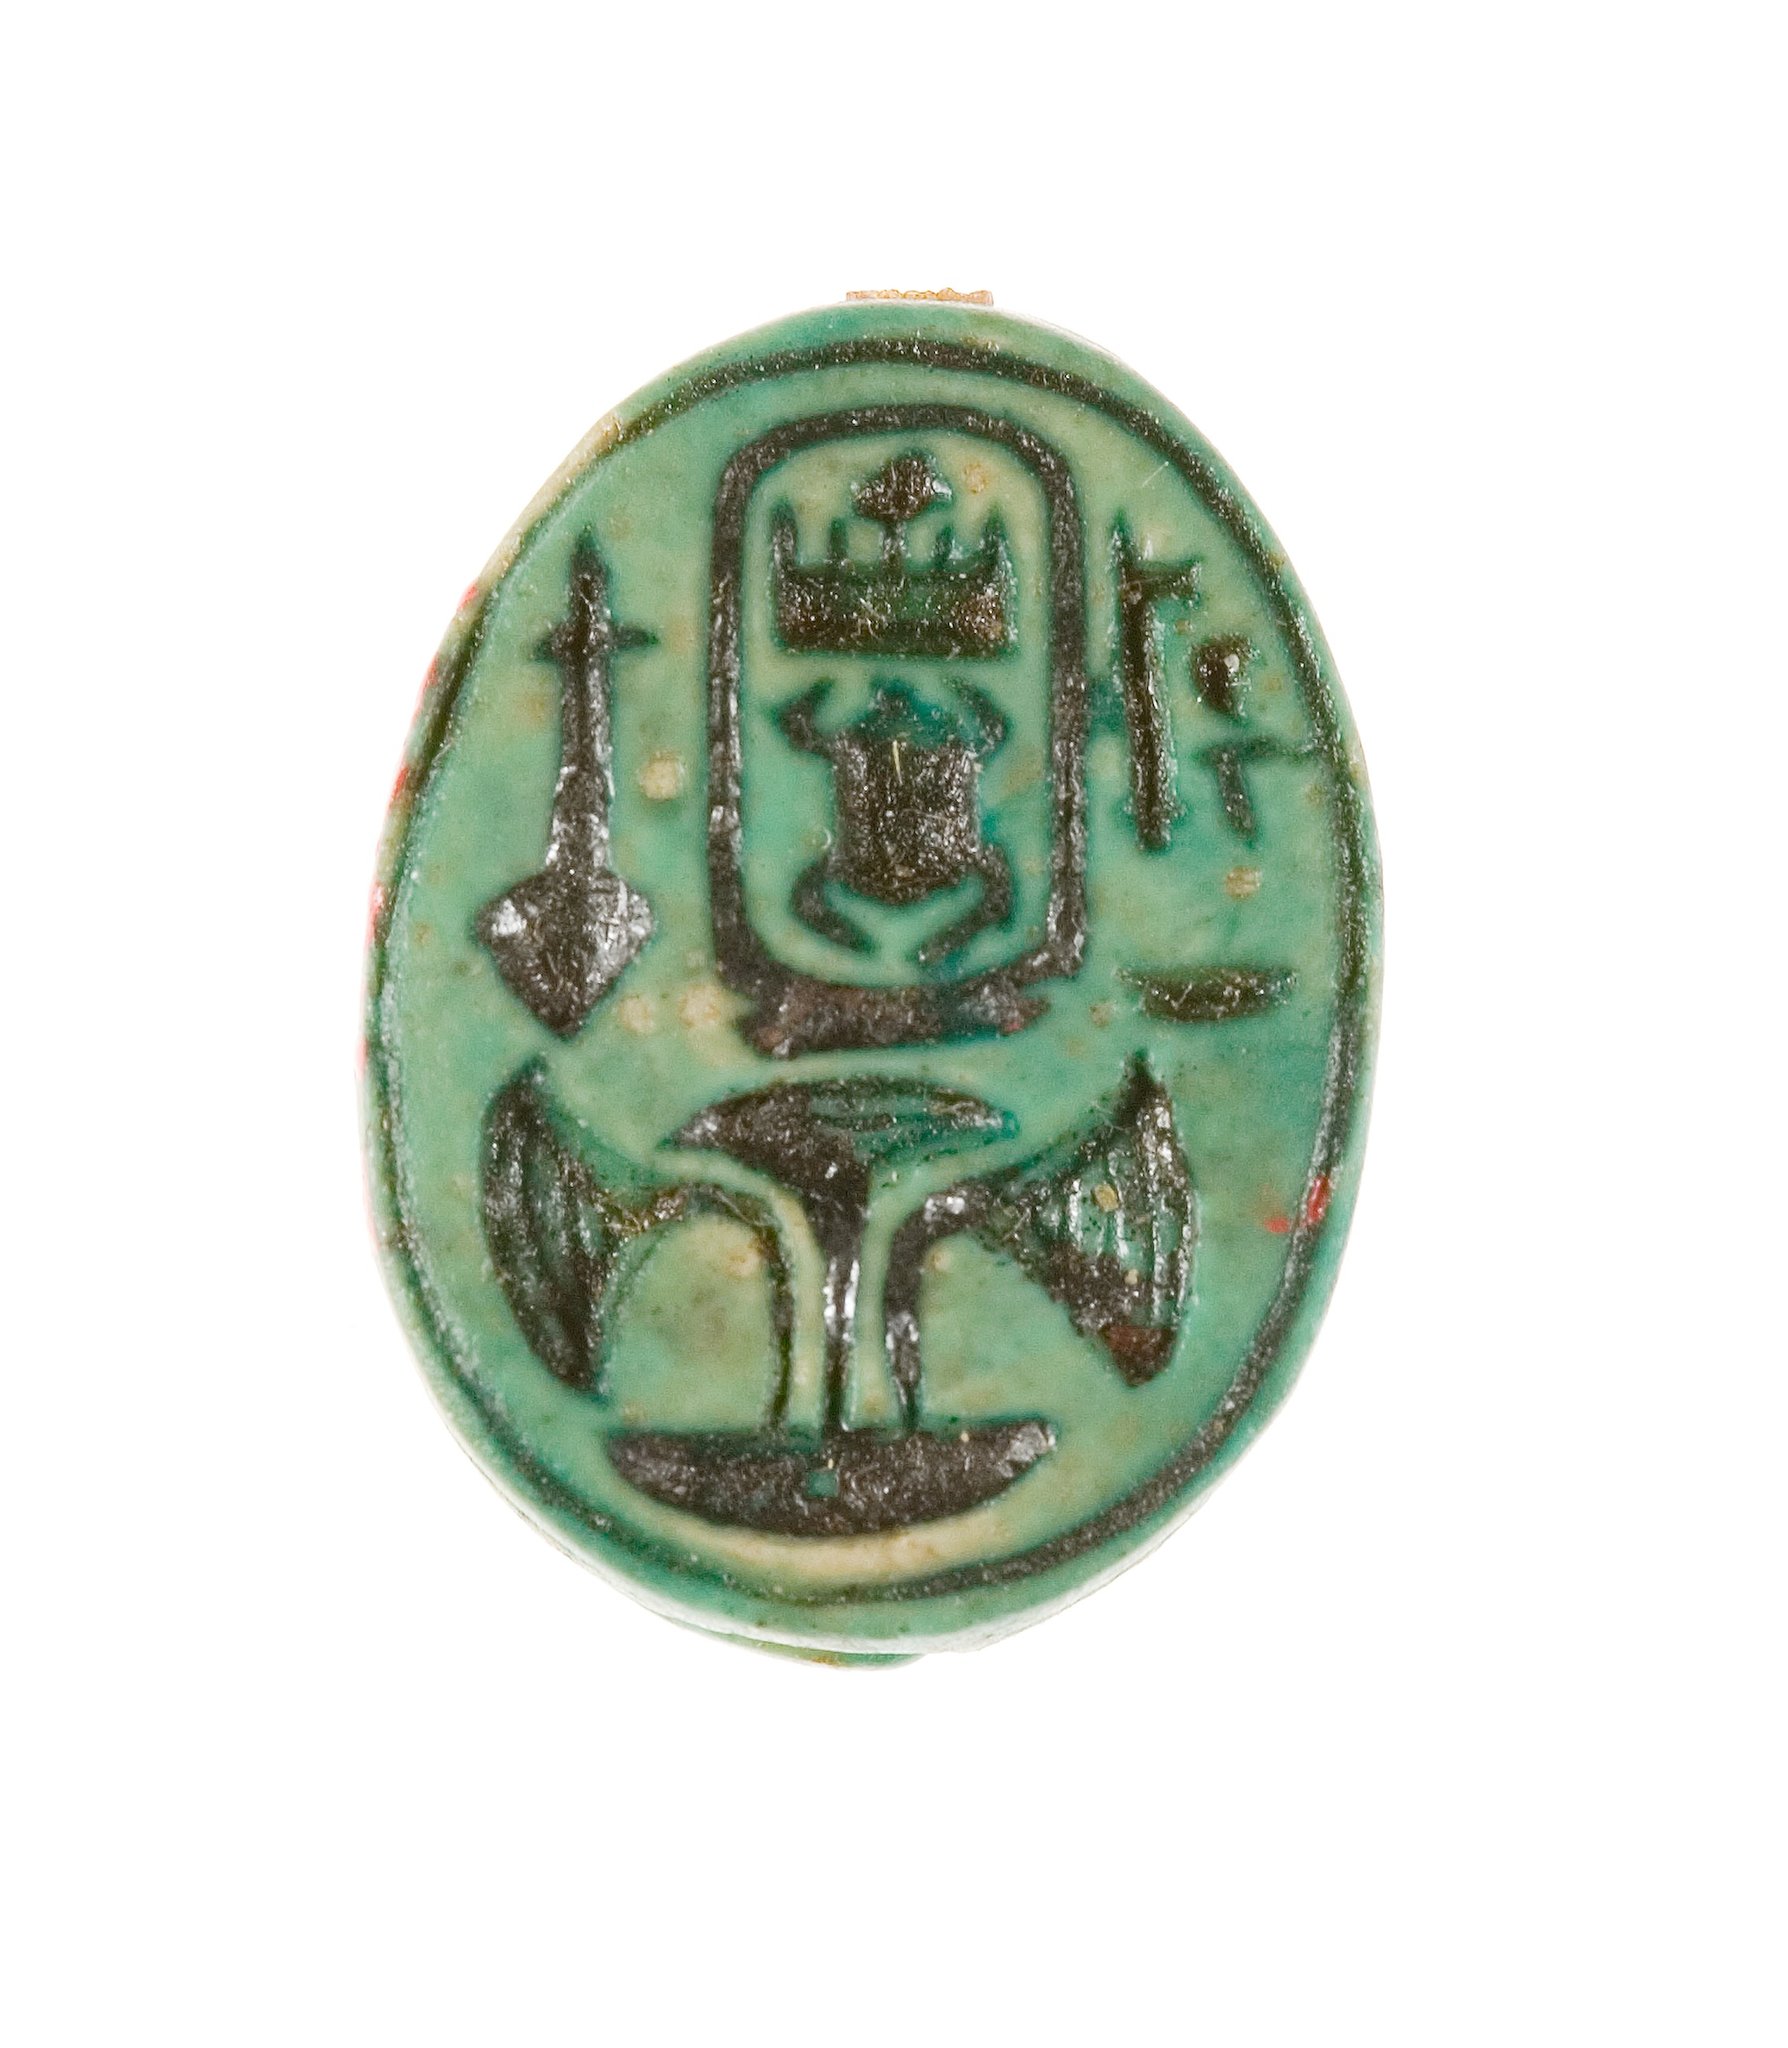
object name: scarab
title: Scarab Inscribed with the Throne Name of Thutmose III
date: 1479-1458 BCE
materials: stone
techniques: glazing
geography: egypt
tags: hieroglyphs,scarabs